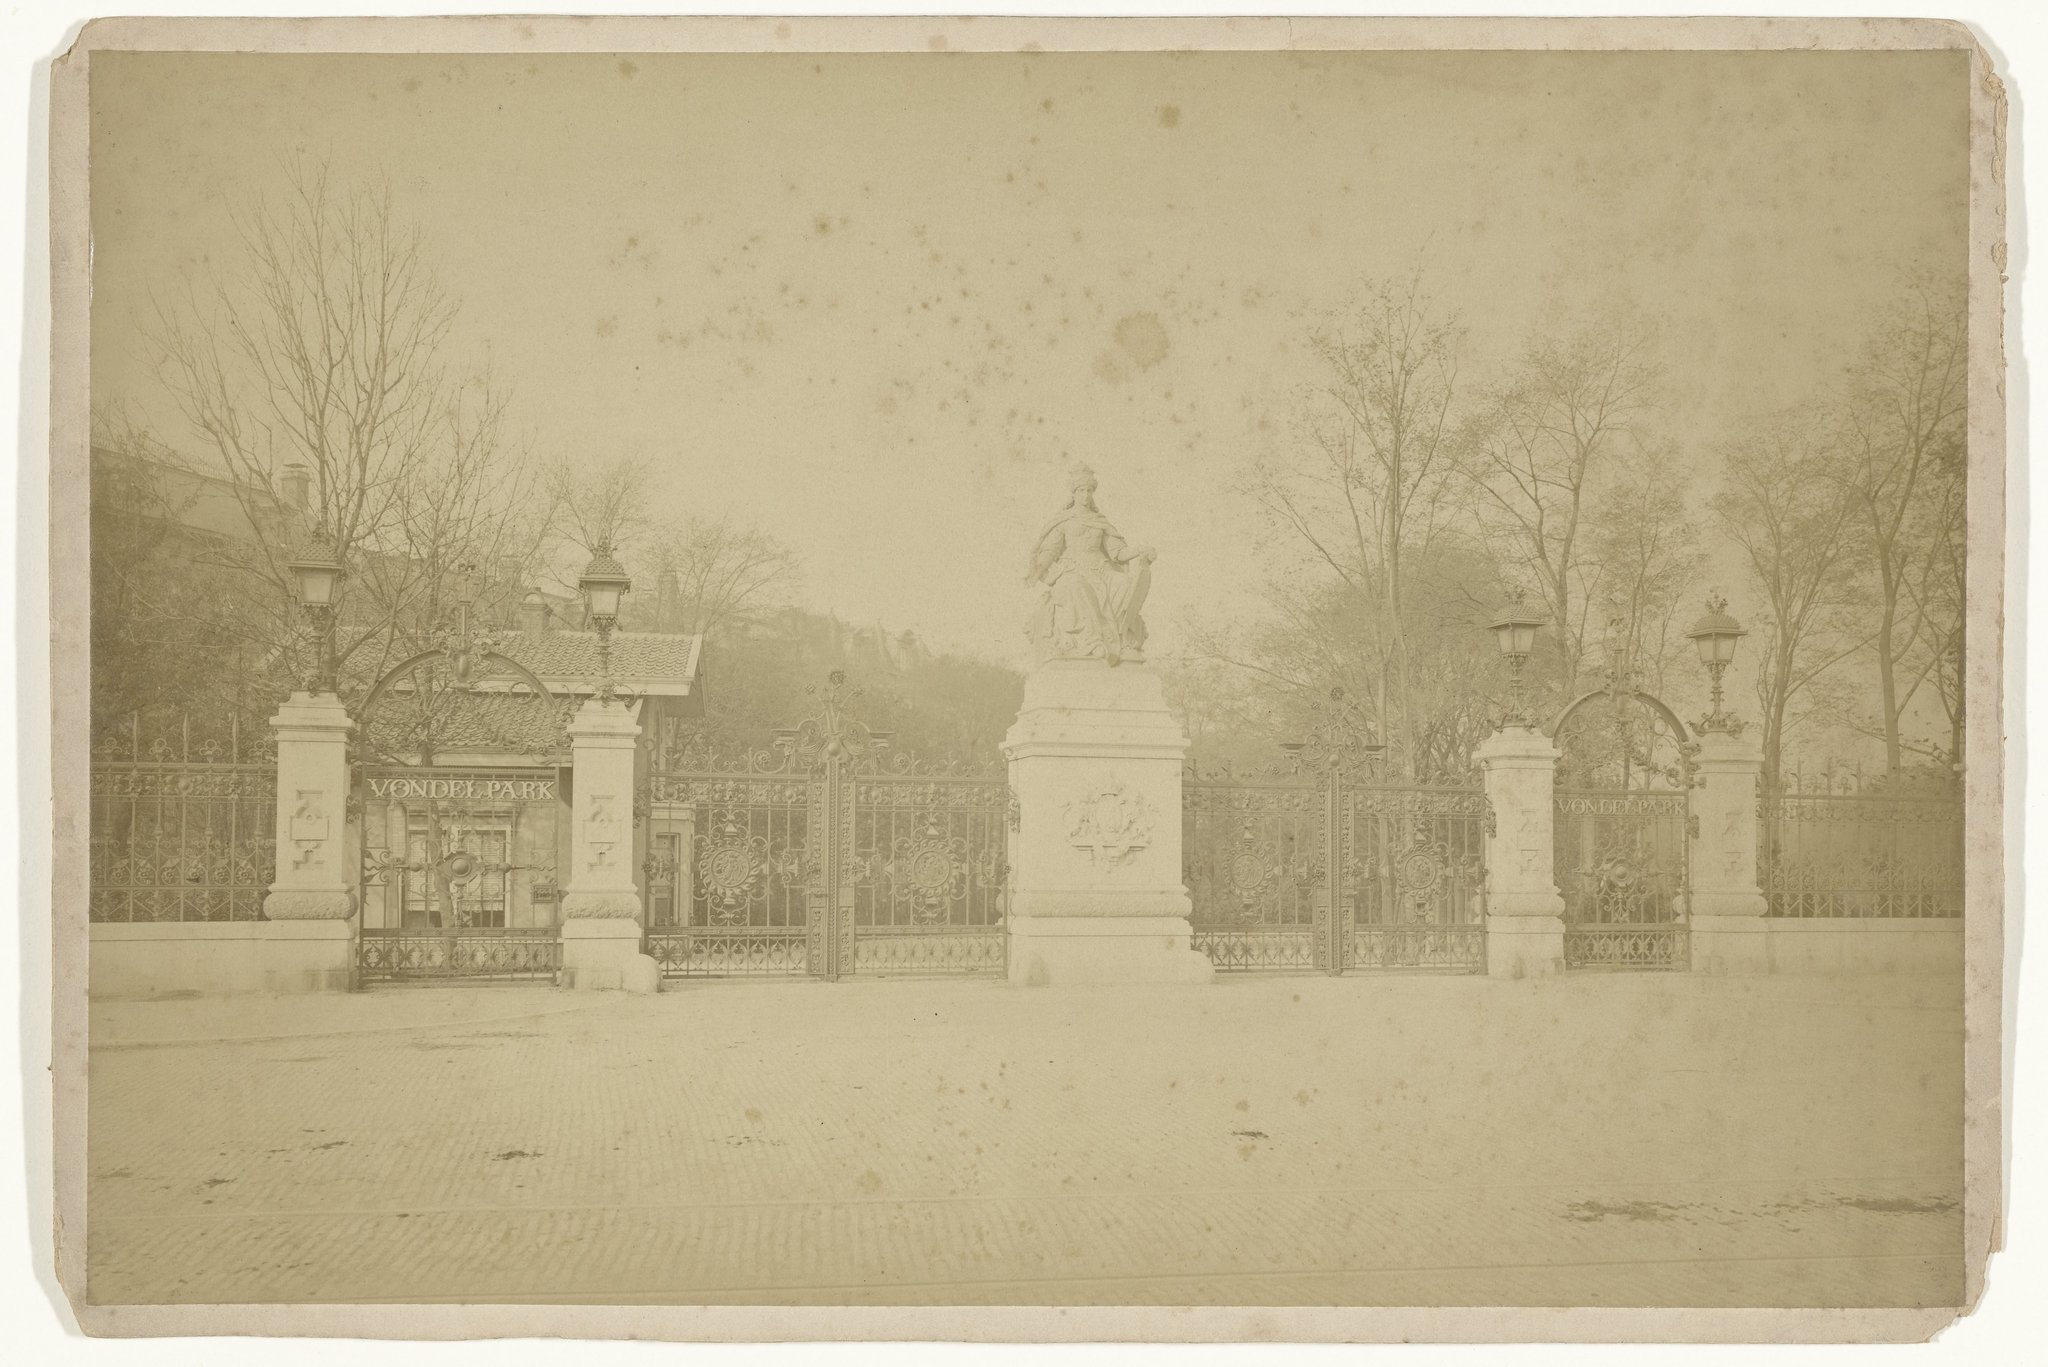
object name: photograph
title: Ingang van het Vondelpark bij de Stadhouderskade in Amsterdam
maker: Anonymous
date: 1850-1900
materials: paper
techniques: albumen print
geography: amsterdam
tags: gate, entrance, public gardens, park